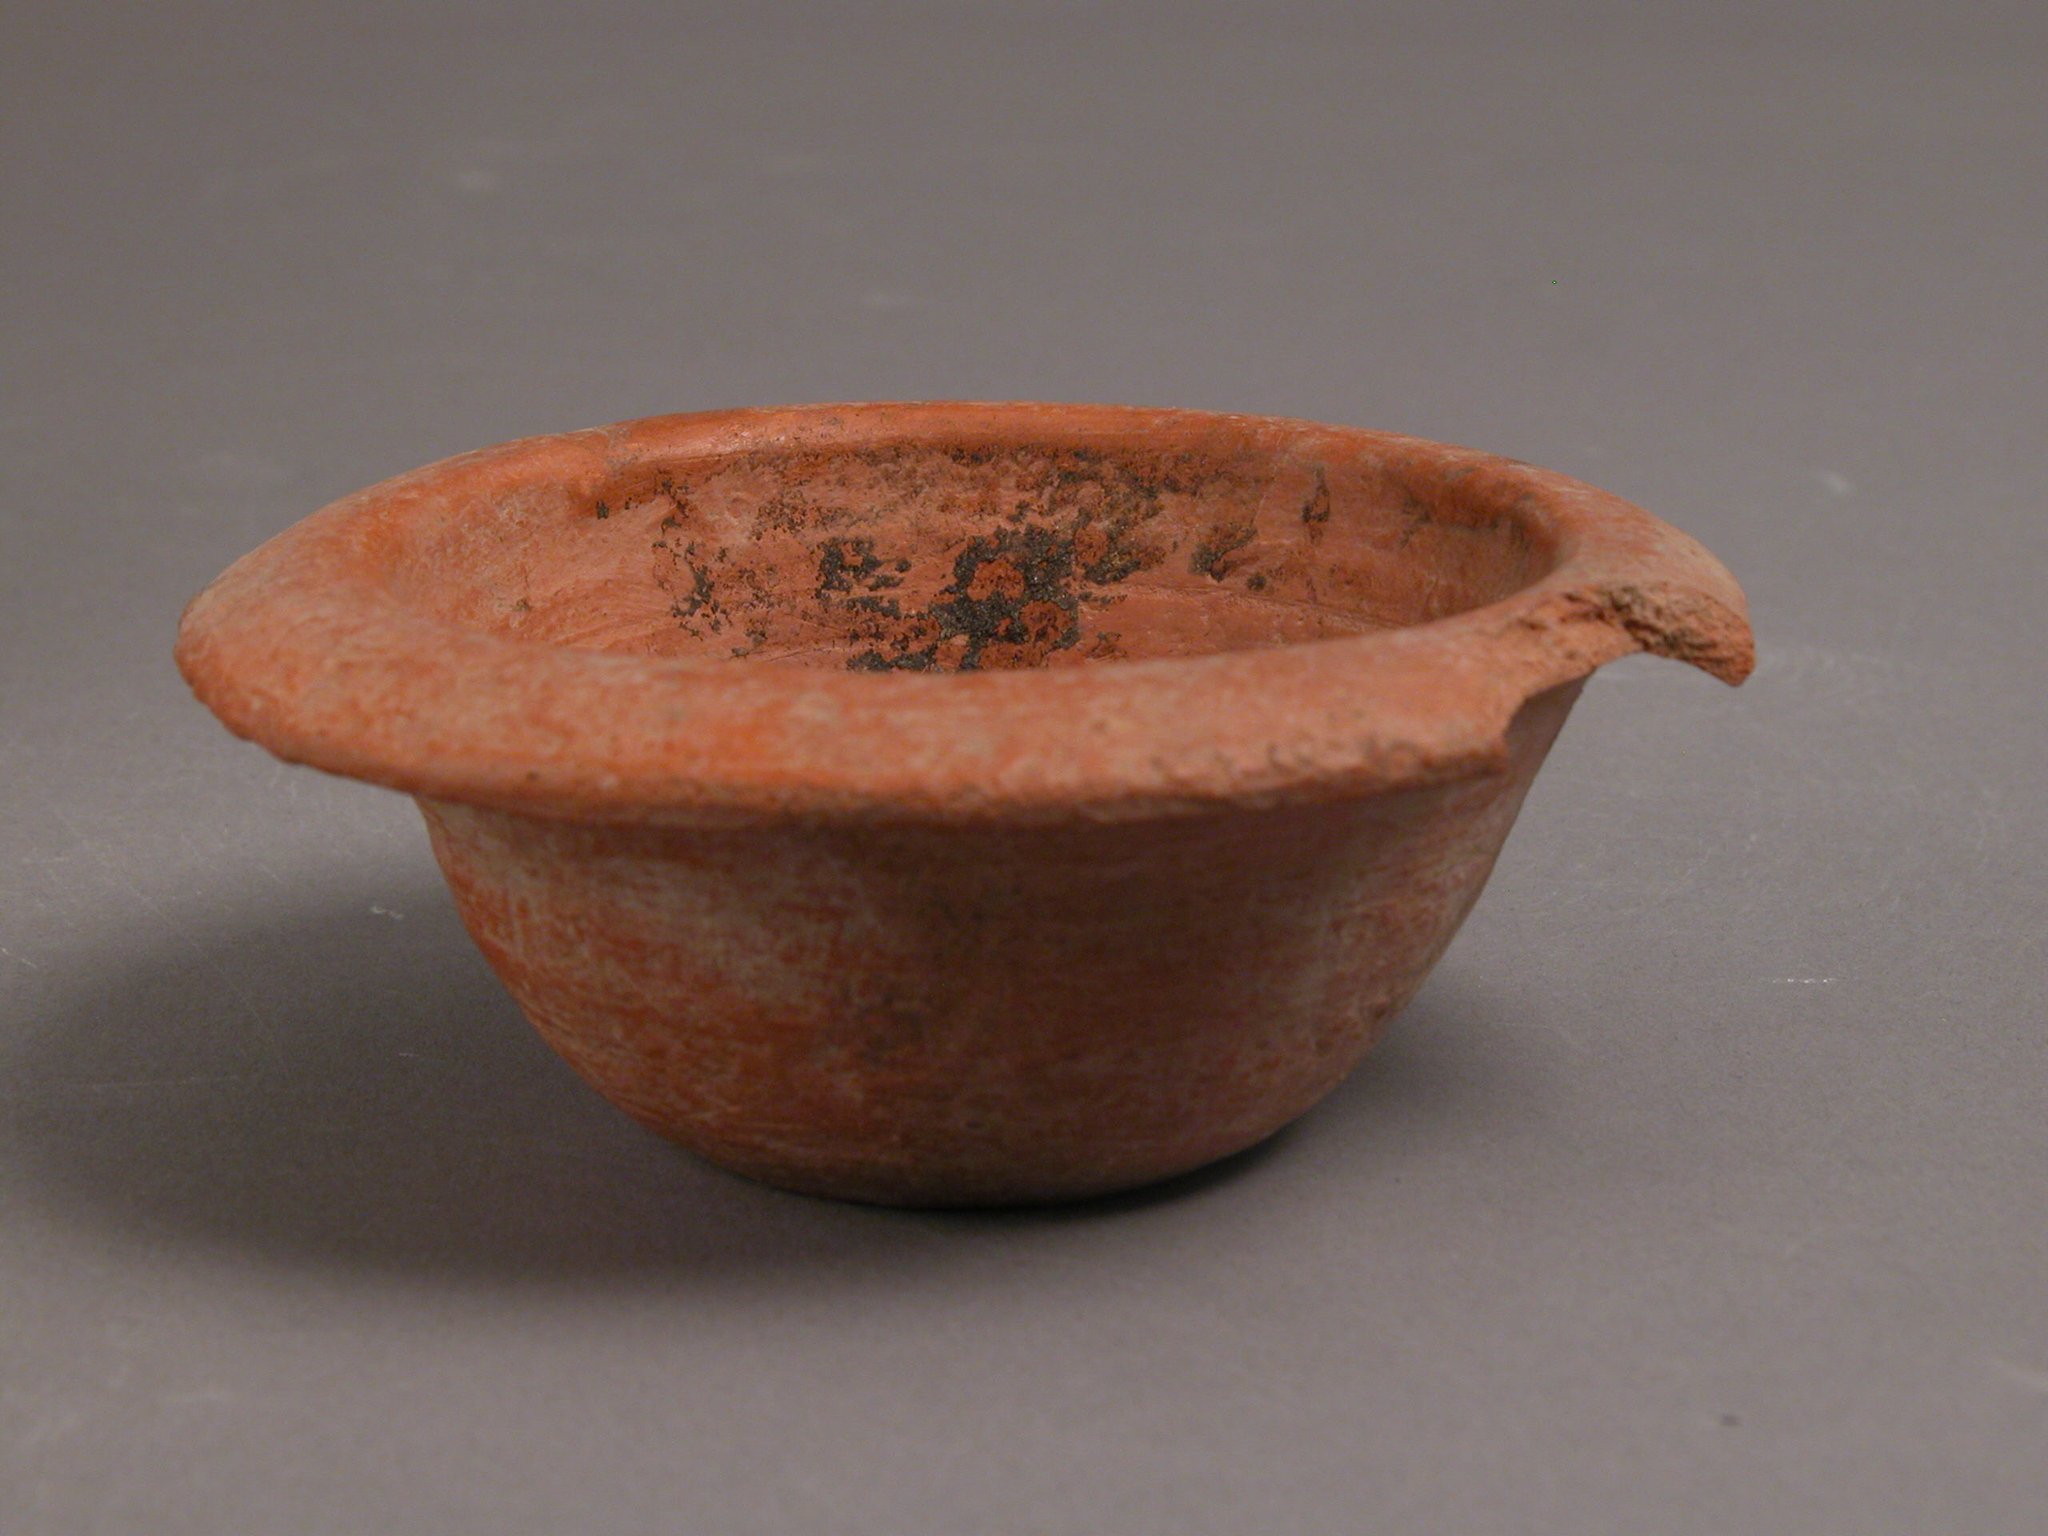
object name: bowl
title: Nesting Bowl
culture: coptic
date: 301-700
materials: earthenware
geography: egypt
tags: bowls